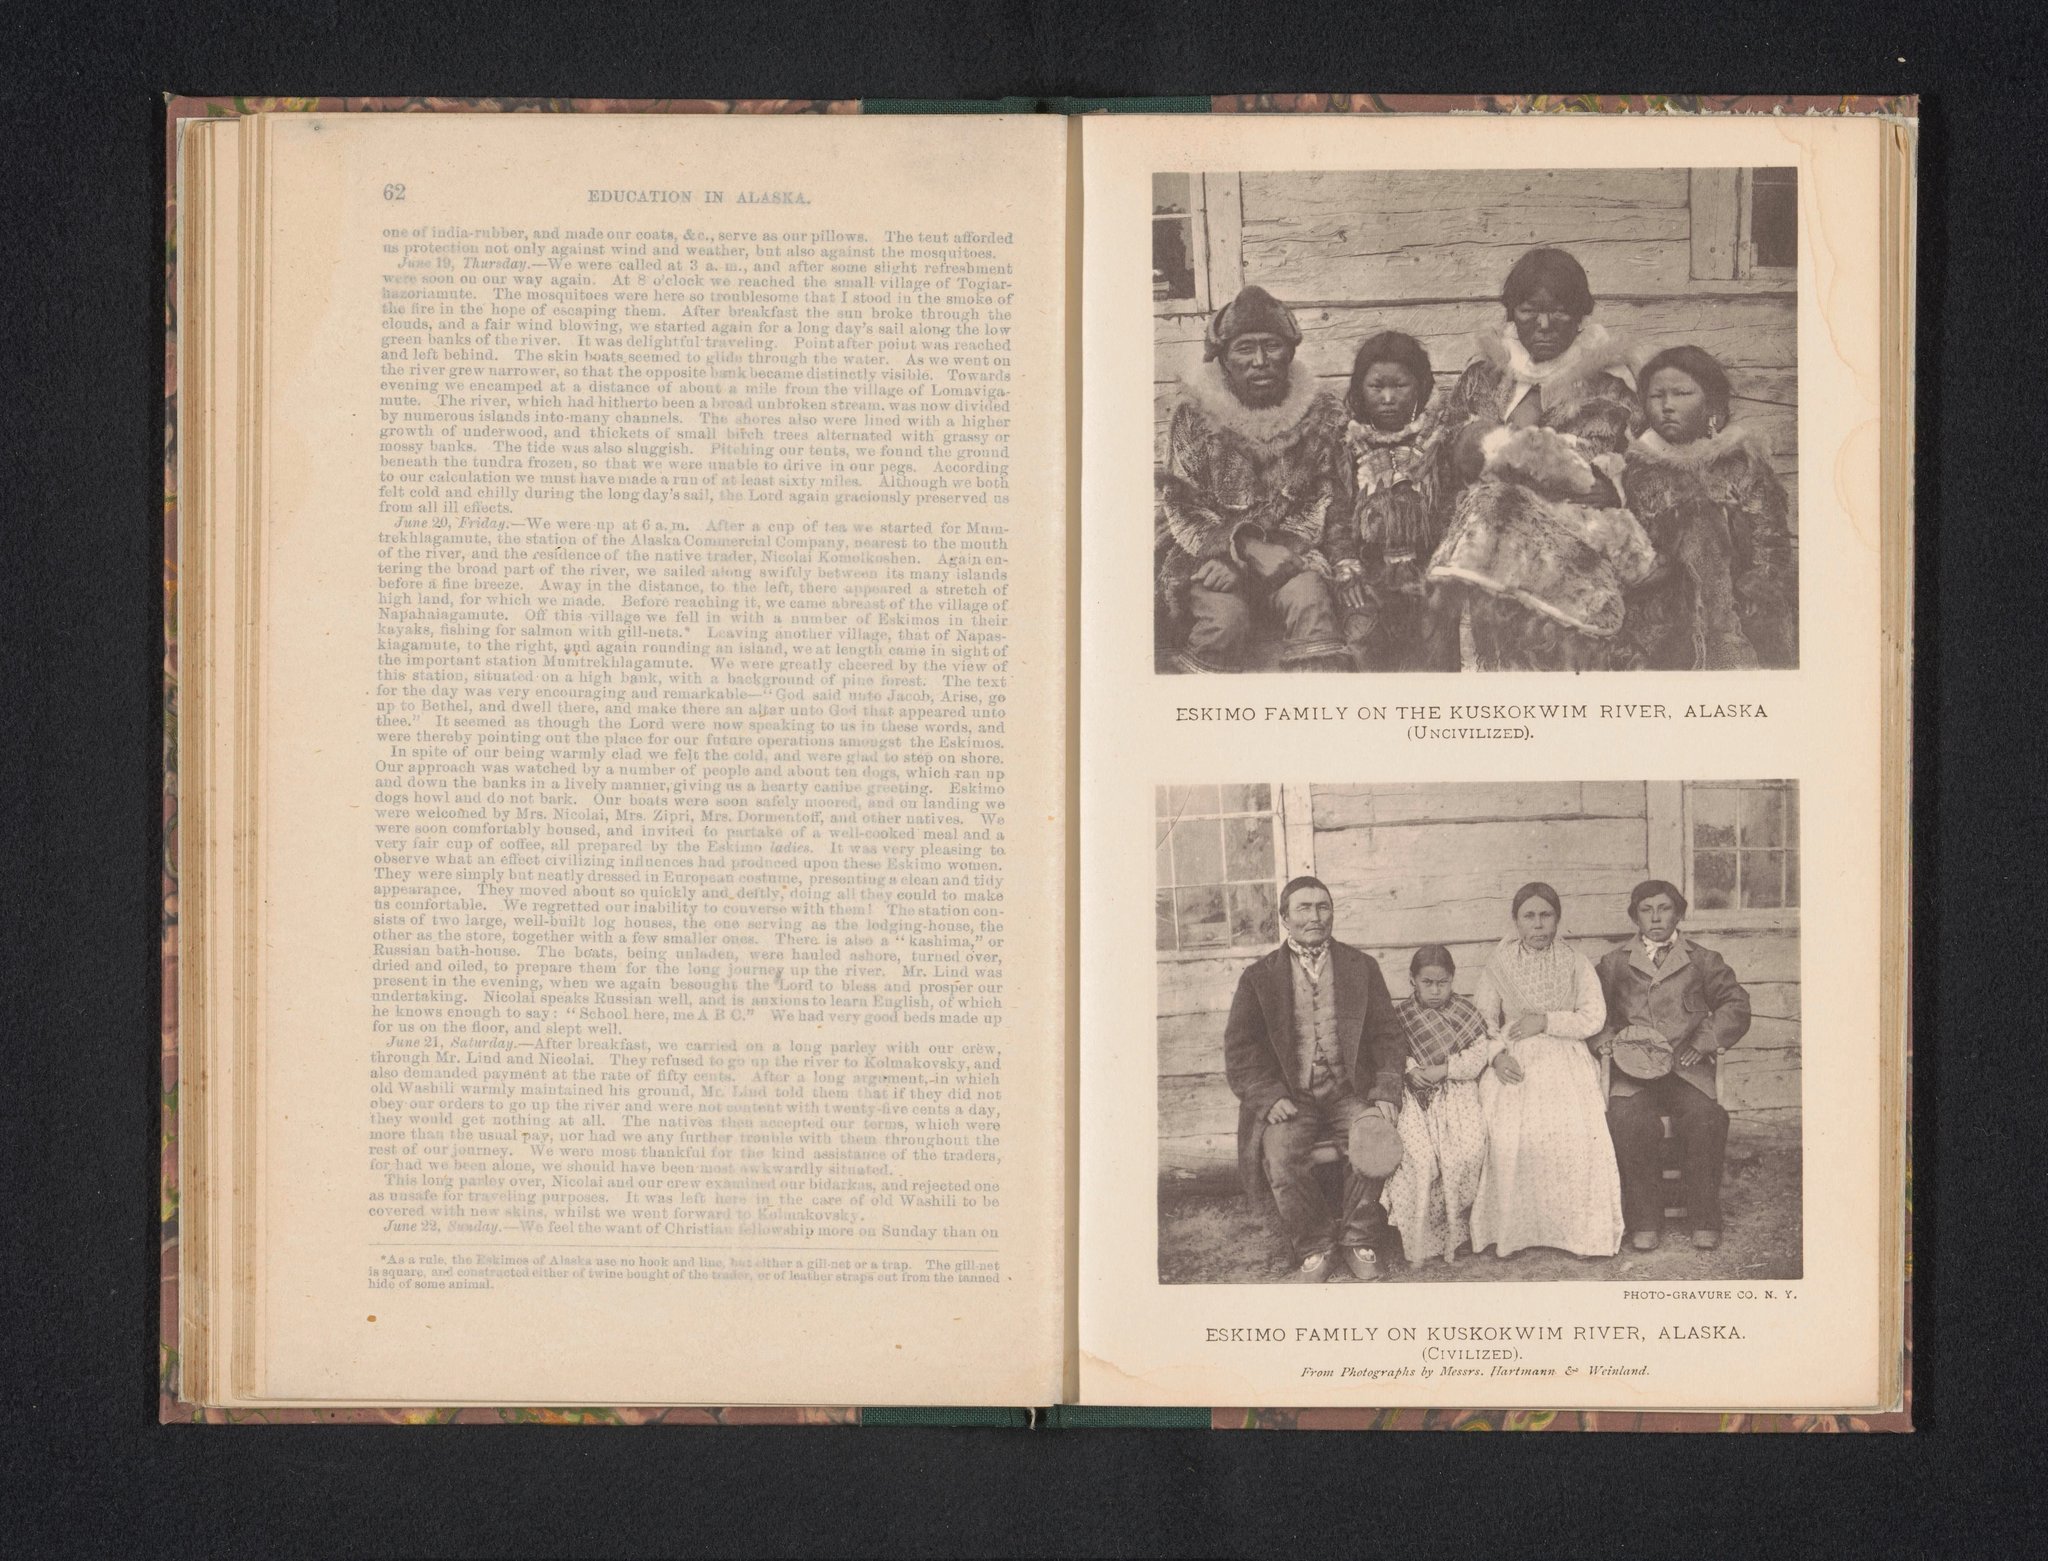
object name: photomechanical print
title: Eskimo family on the Kuskokwim River, Alaska (civilized)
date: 1881-1886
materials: paper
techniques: photograph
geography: alaska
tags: indigenous peoples of the arctic regions: yupik, anonymous historical persons portrayed in a group, in a group-portrait